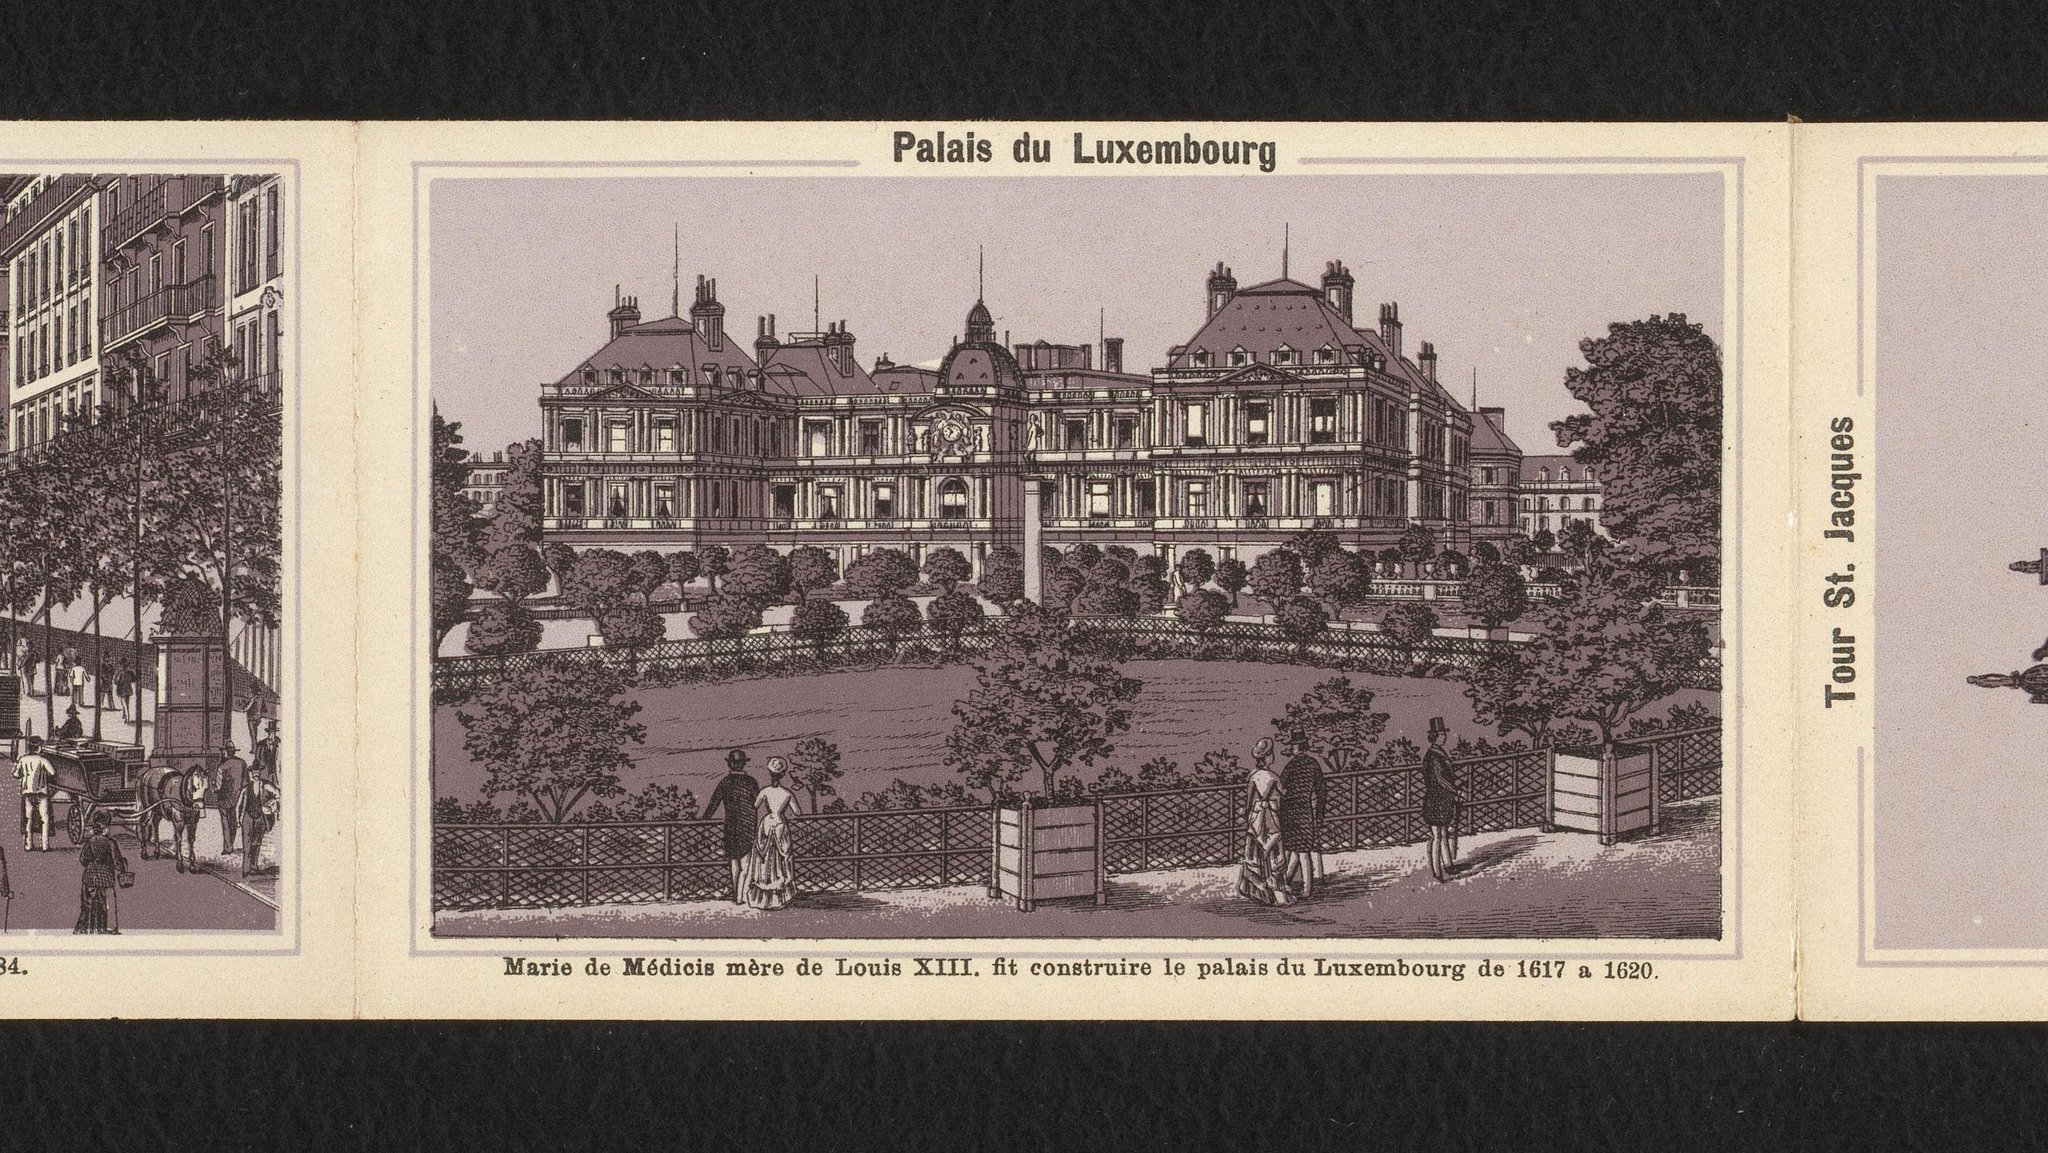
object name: print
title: Palais du Luxembourg. Marie de Médicis, mère de Louis XIII, fit construire le palais du Luxembourg de 1617 à 1620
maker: Anonymous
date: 1890-1910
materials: cardboard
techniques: lithograph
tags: public gardens, park (+ city(-scape) with figures, staffage), palace